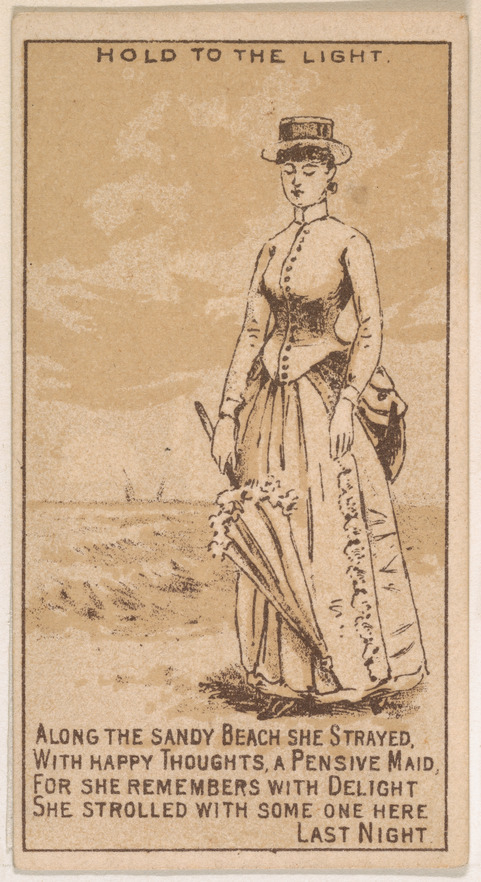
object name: print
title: Along the Sandy Beach She Strayed..., from the Magic Changing Cards series (N223) issued by Kinney Tobacco Company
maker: kinney brothers tobacco company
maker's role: publisher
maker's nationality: american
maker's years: 1869-2011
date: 1889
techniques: color lithograph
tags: women